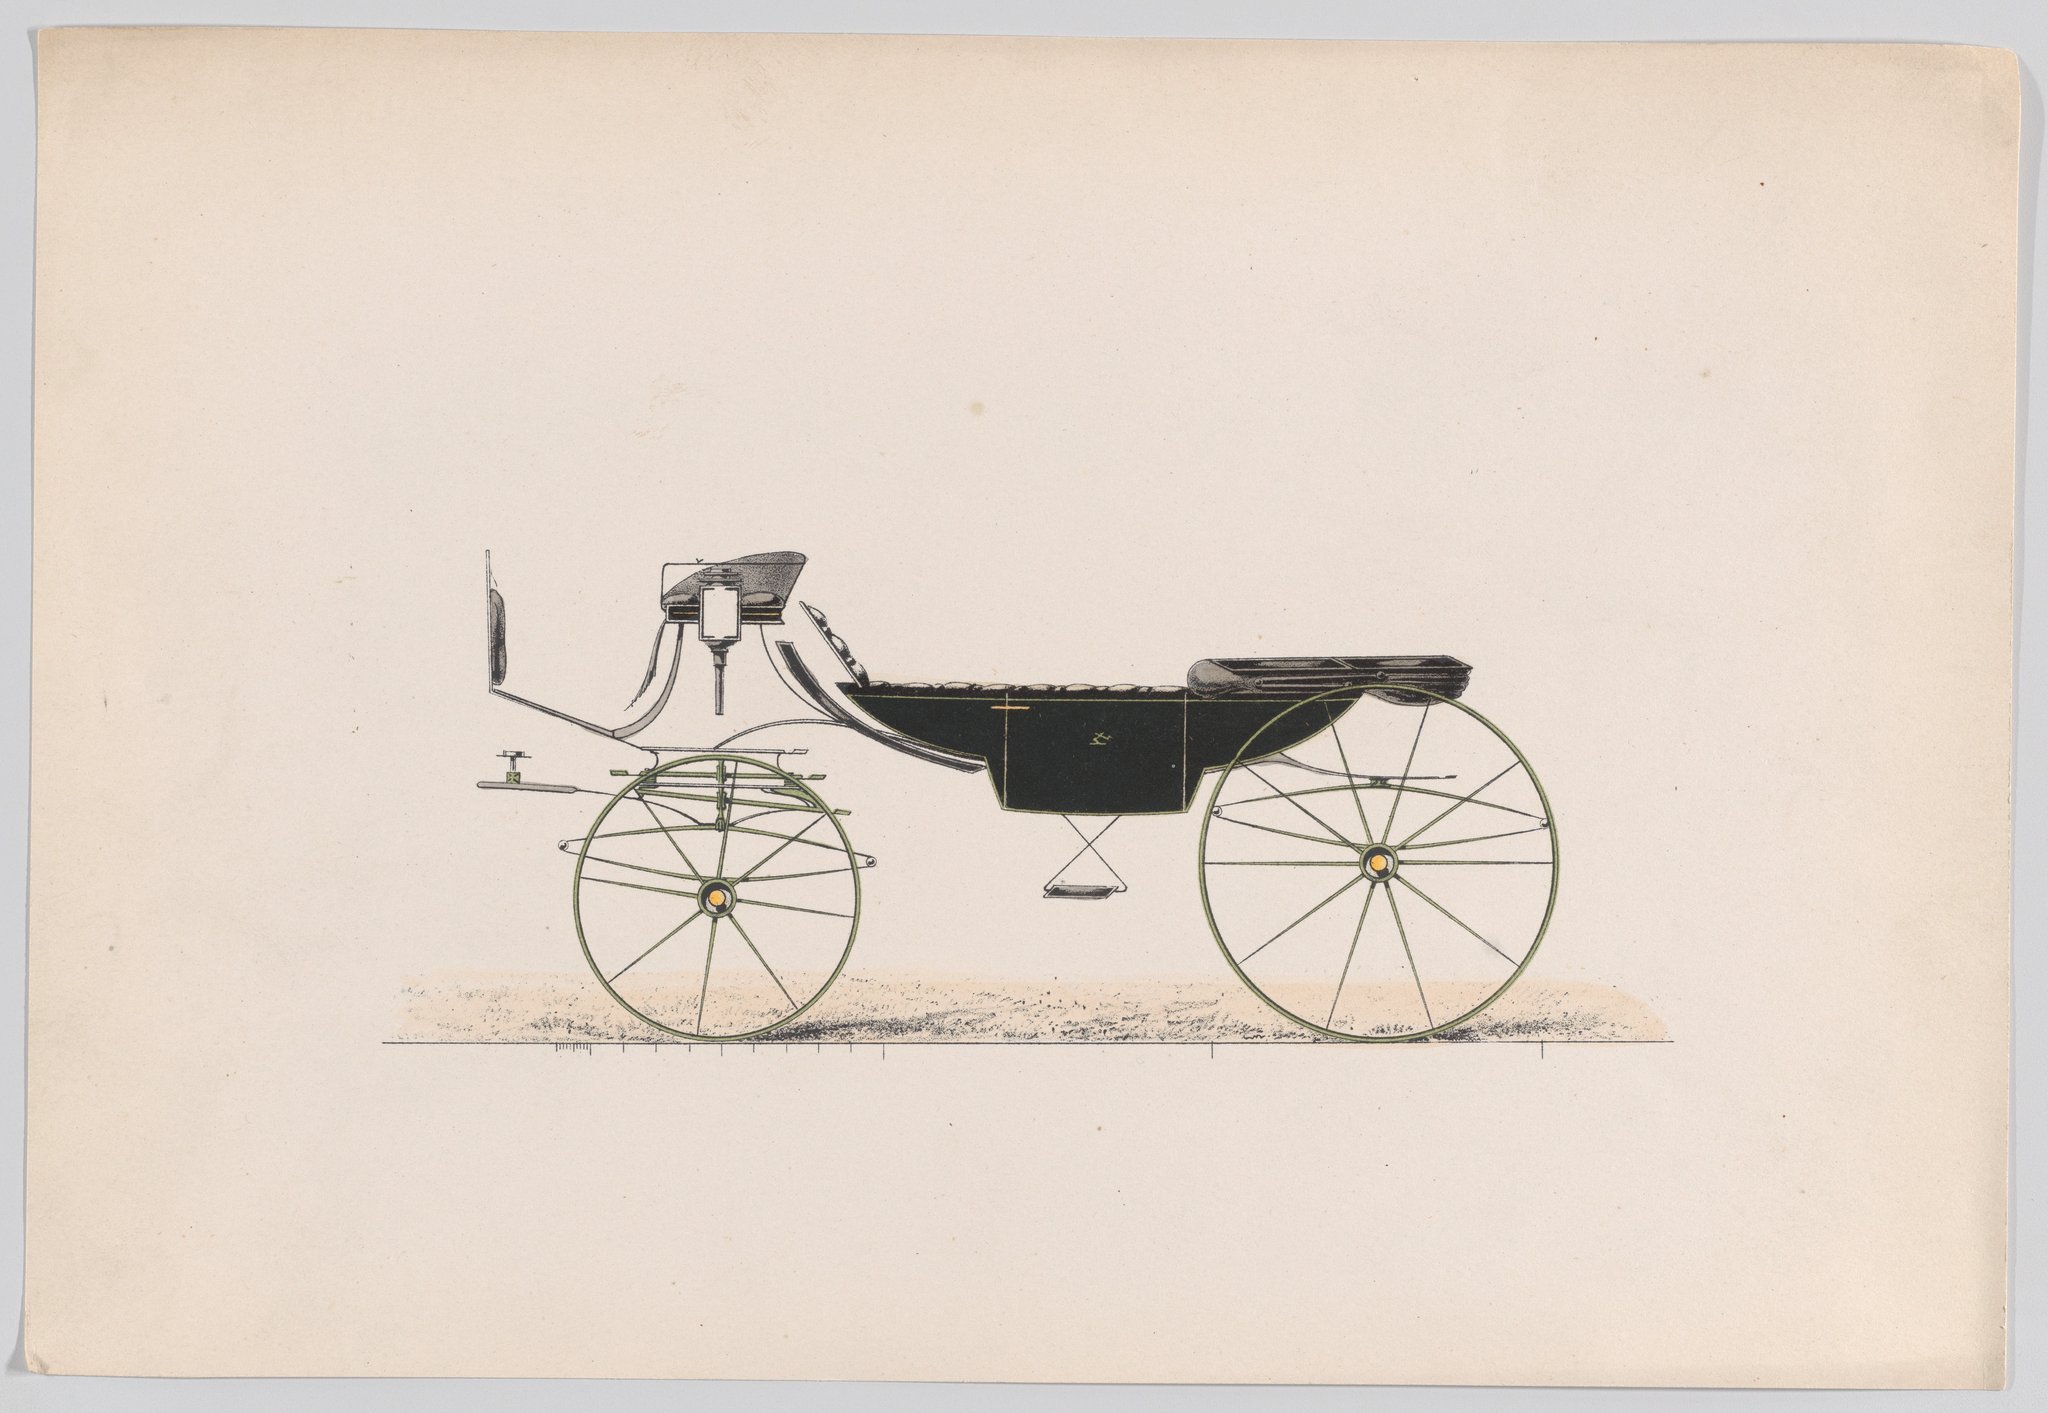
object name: print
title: Design for Vis-A-Vis Carriage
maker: anonymous, french, 19th century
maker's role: artist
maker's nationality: french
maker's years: 1800-1900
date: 1880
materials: gum arabic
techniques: hand coloring, lithograph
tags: carriages